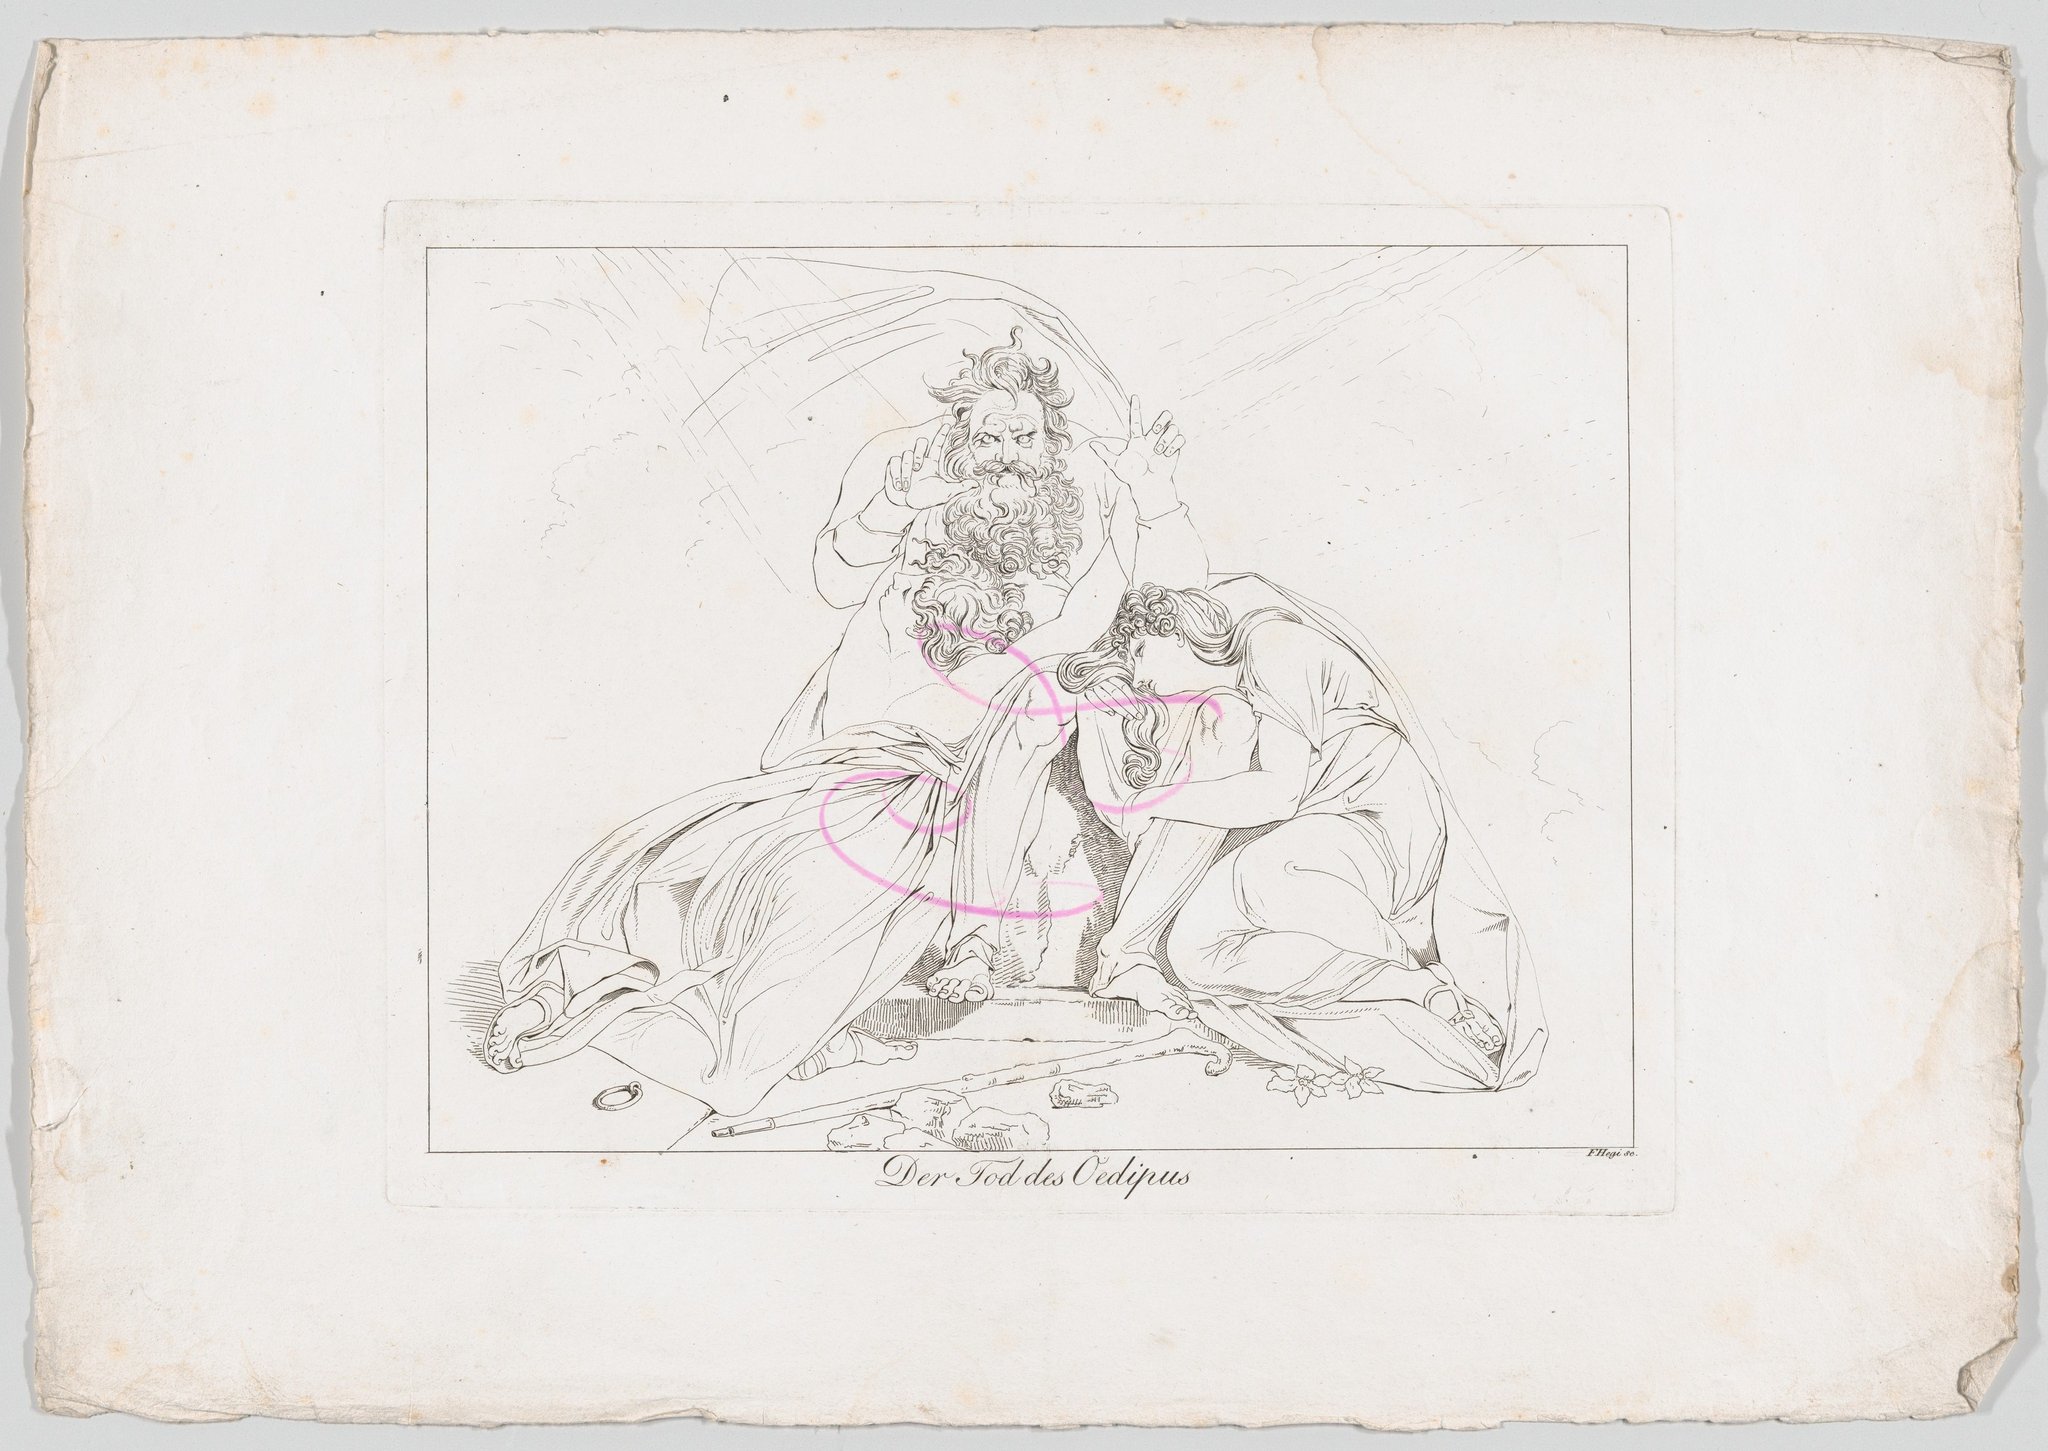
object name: print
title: Der Tod des Oedipus (The Death of Oedipus)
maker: franz hegi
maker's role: engraver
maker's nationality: swiss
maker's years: 1774-1850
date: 1806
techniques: engraving, etching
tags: women,oedipus,death